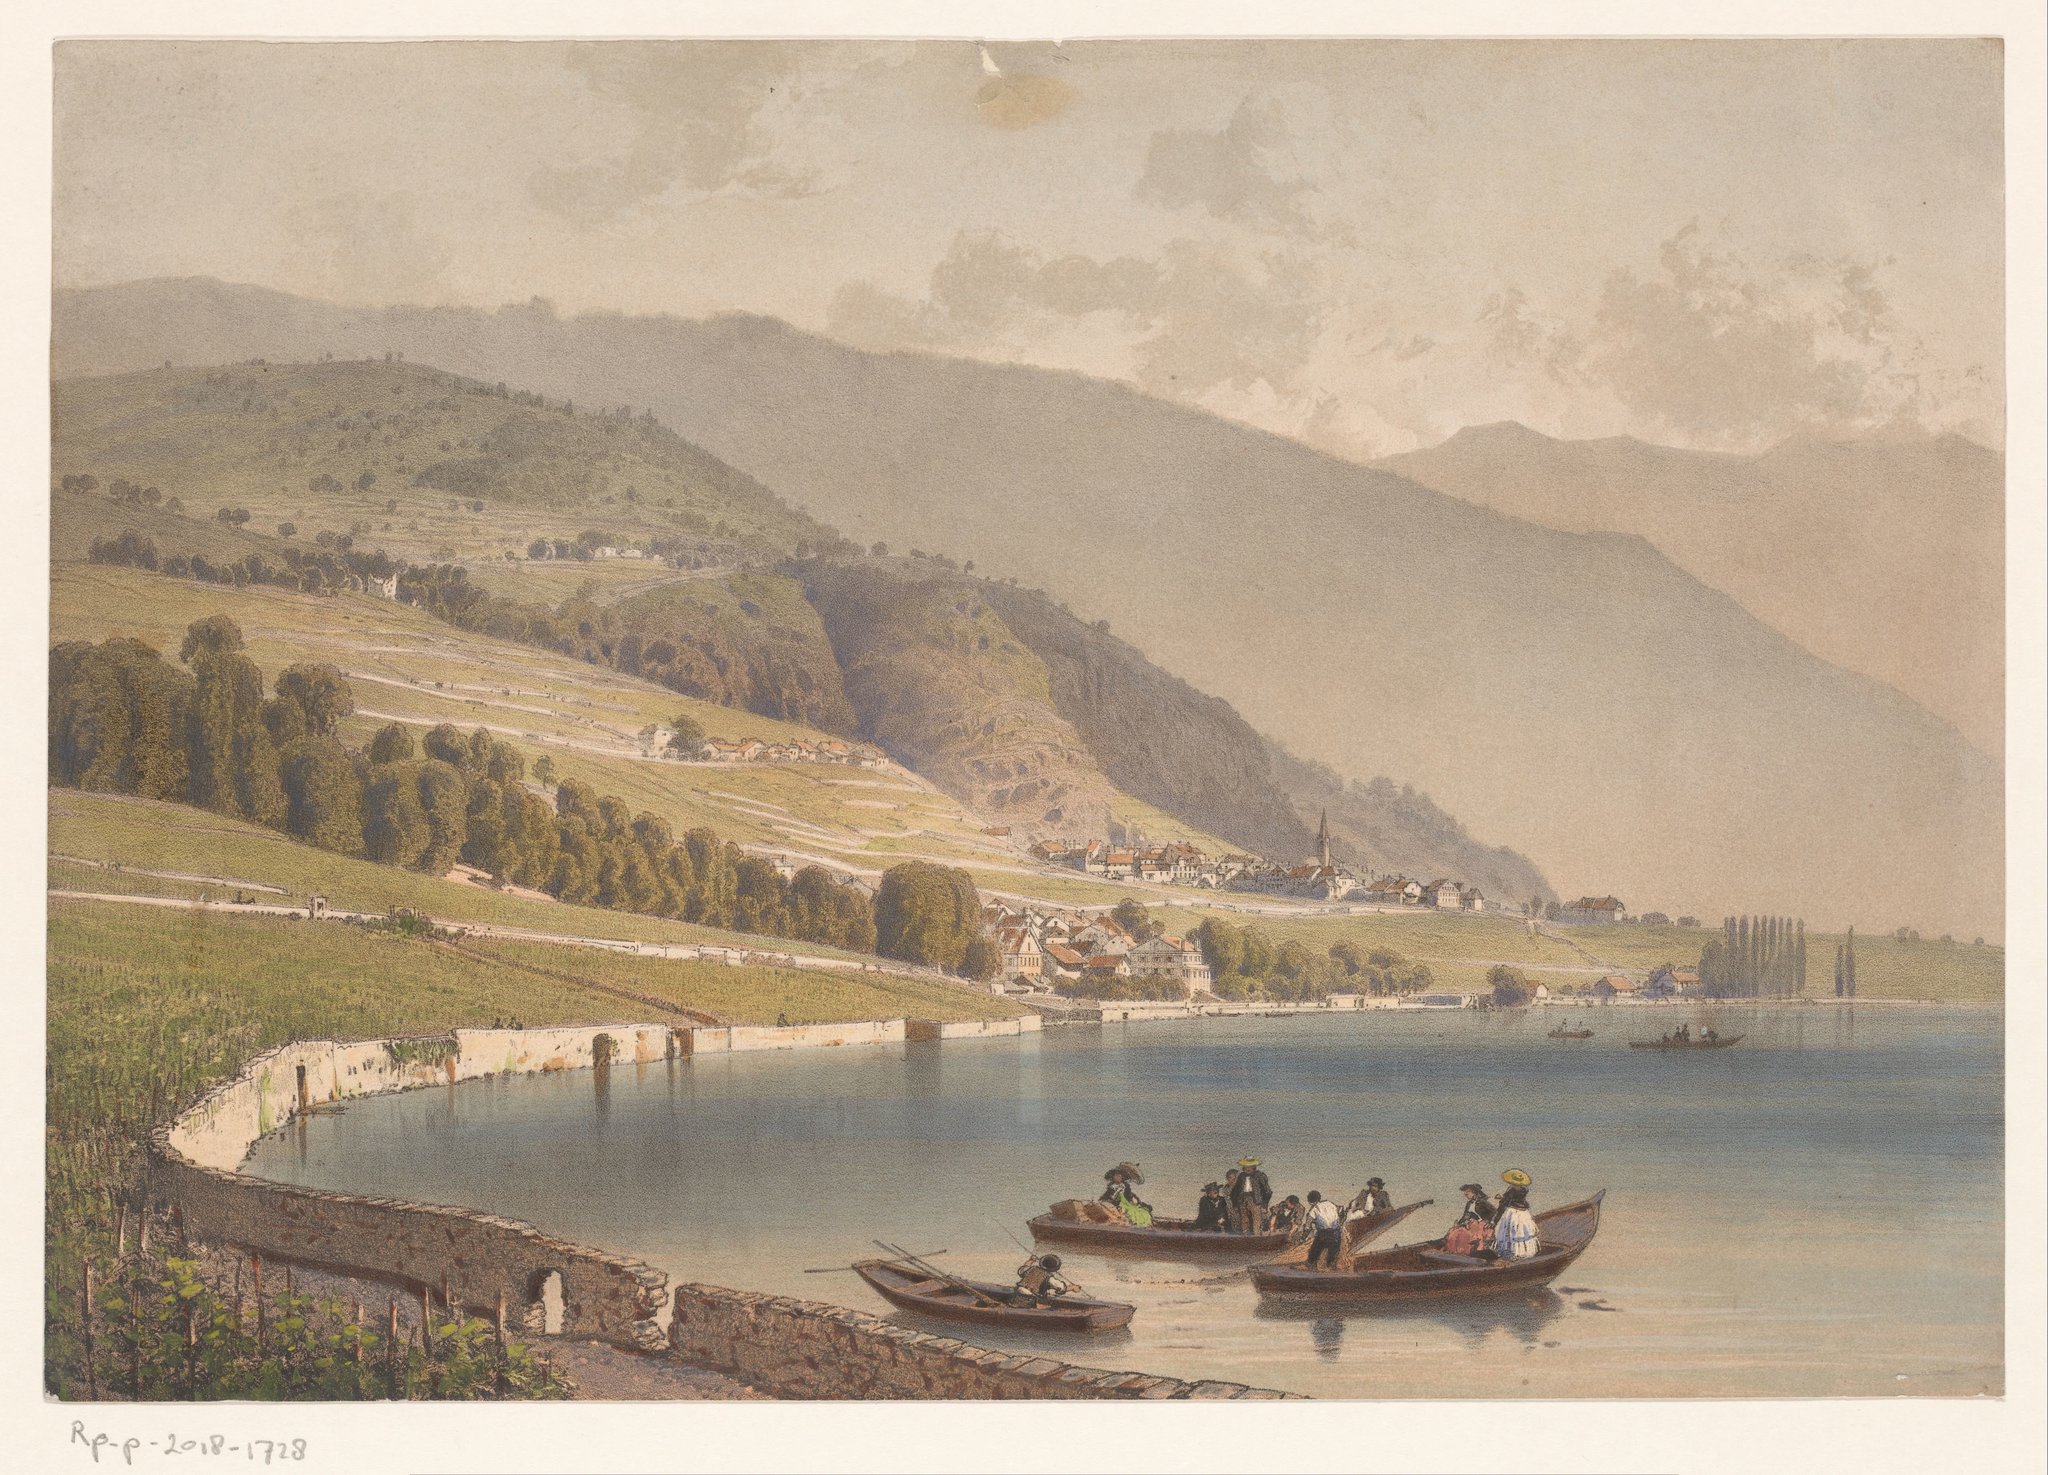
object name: print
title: Gezicht op de kerk van Montreux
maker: Anonymous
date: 1800-1899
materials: paper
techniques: etching, hand coloring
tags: church (exterior), lake, mountains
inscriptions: collector's mark: Lugt 2228